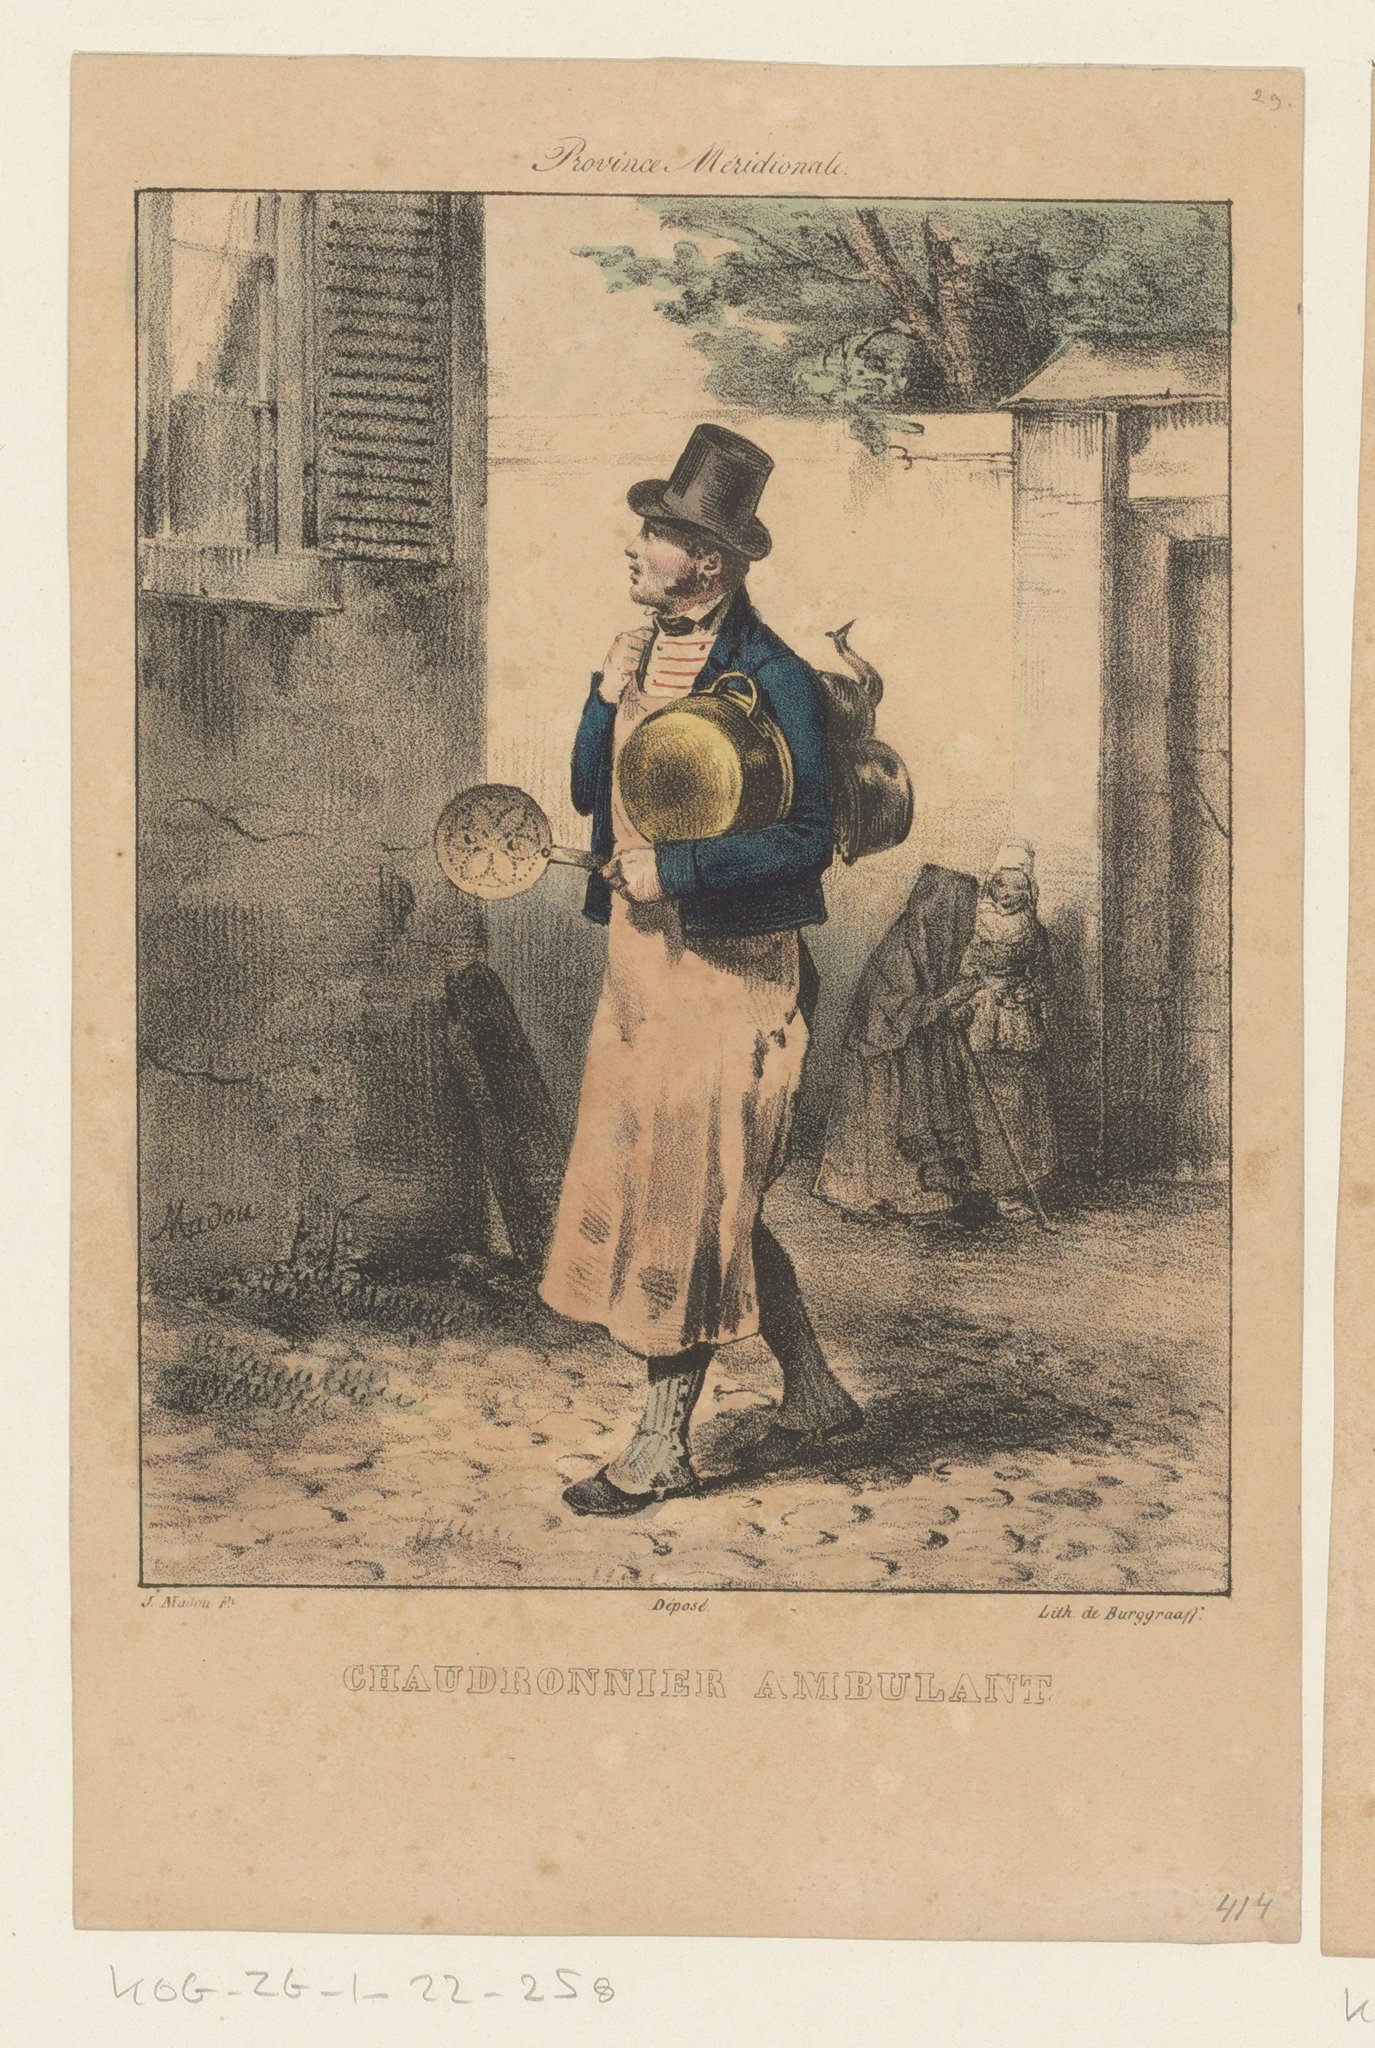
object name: print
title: Costumes du peuple de toutes les provinces des Pays-Bas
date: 1835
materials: paper, watercolor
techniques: hand coloring, lithograph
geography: brussels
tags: coppersmith, brassworker, street-trader, clothes, costume (+ men's clothes), folk costume, regional costume, southern netherlands, brussels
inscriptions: collector's mark: Lugt 1641, collector's mark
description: Van den Burggraaff wilde een serie (twintig afleveringen met telkens vier platen) uitgeven met kostuums uit alle provincies van Nederland en België onder de titel 'Costumes du peuple de toutes les provinces des Pays-Bas'. Hij begint met deze serie in 1825 en eindigt hiermee bij de dertiende aflevering in 1830. Omdat in 1830 België zich afsplitst van Nederland geeft hij de prenten daarna apart uit onder de titels 'Costumes de peuple Hollandais' en 'Collection de costumes du peuple des provinces de la Belgique' (1835).